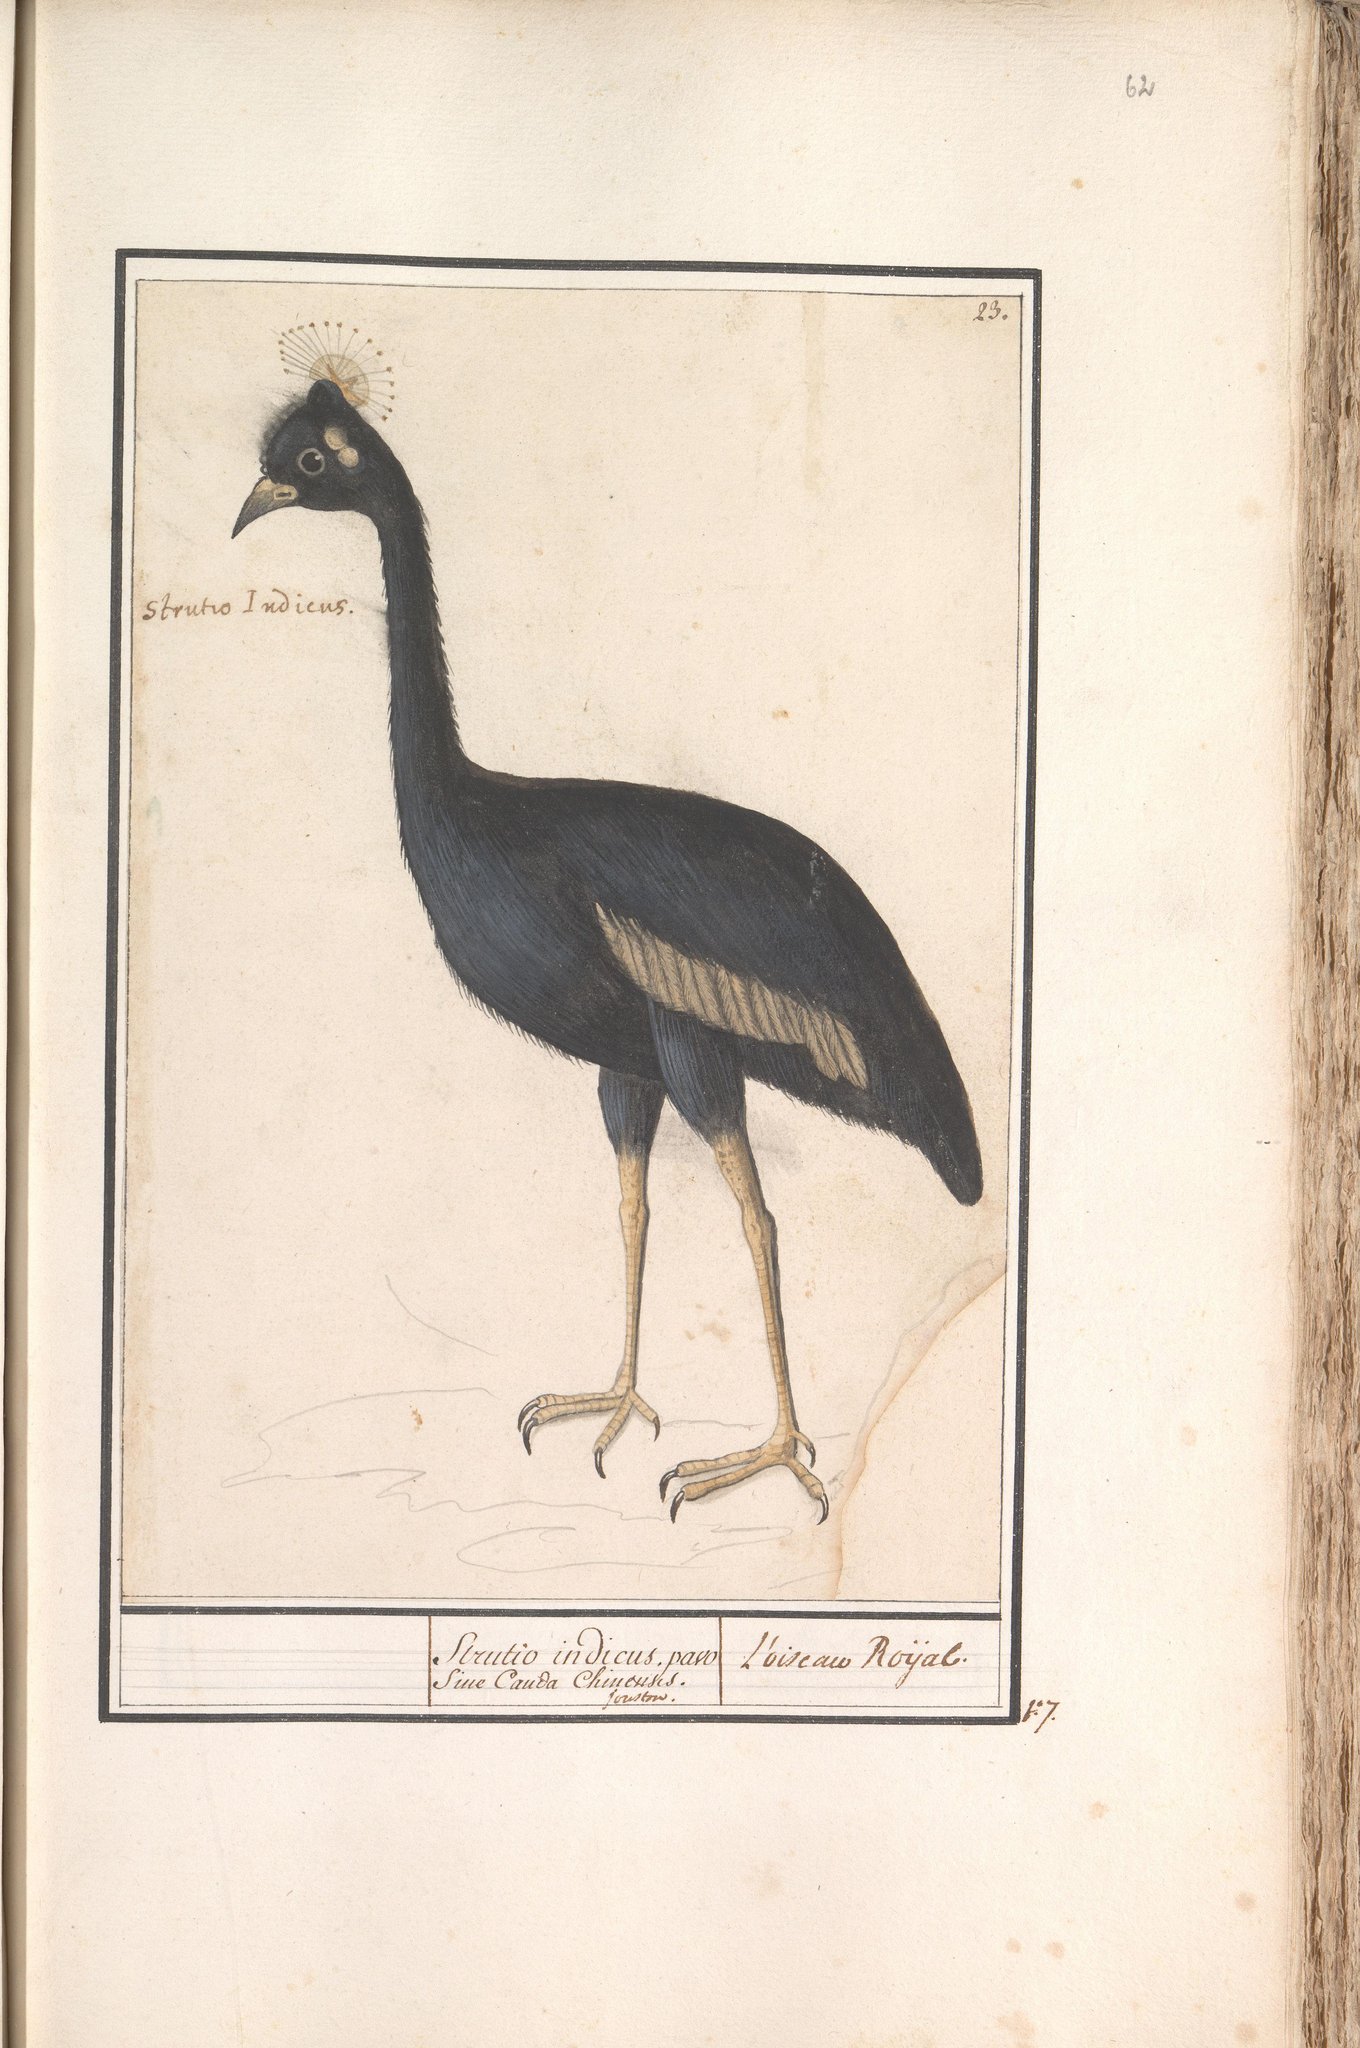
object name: drawing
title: Black Crowned Crane (Balearica pavonina)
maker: anselmus boëtius de boodt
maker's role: draughtsman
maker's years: 1550-1632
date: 1596-1610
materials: chalk, paint, ink, paper, pencil, watercolor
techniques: brush, pen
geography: prague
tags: shore-birds and wading-birds: black-crowned crane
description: De Boodt probably assembled his ‘three large books’ as follows: one for plants, one for animals and one for birds. The latter was apparently damaged (many of the bird studies have a loss at one corner), which may have prompted the 19th-century remounting campaign. Here the lower right corner is missing, but this pavo sine cauda chinensis (literally: ‘peacock without Chinese tail’) – with its gold, feathered ‘crown’ – remained unaffected.